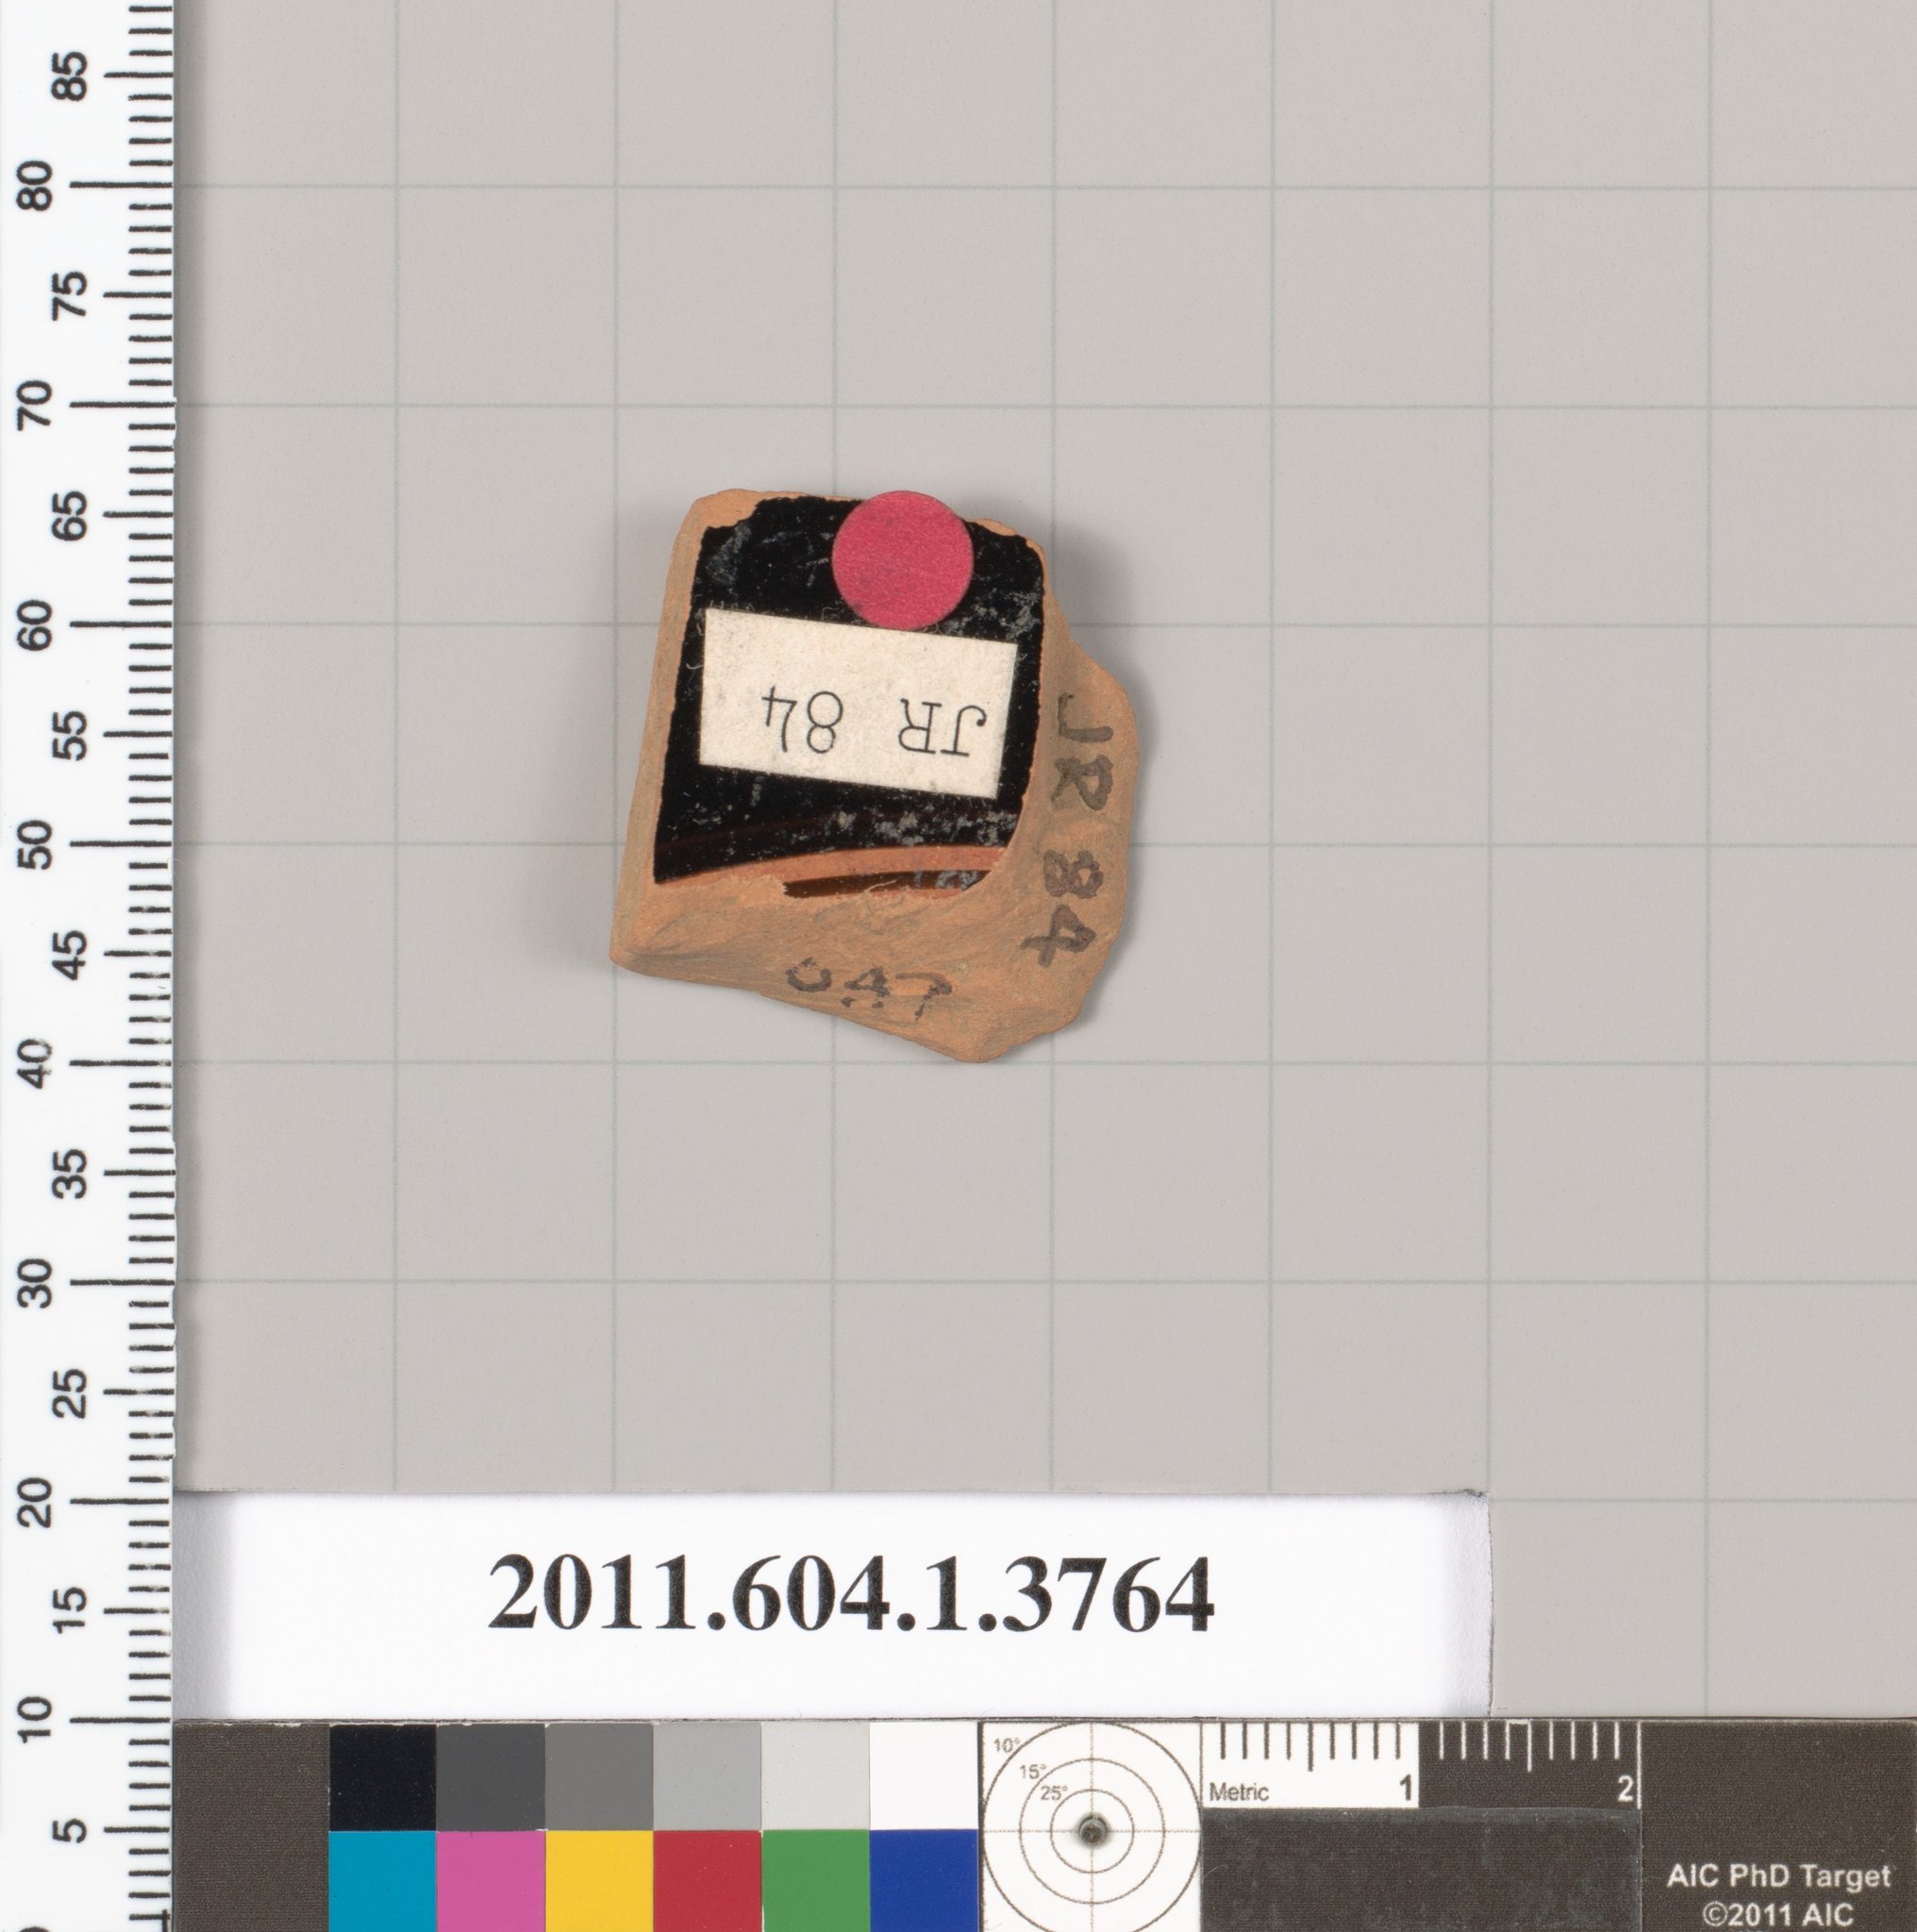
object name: kylix fragment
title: Terracotta fragment of a kylix (drinking cup)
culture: greek, attic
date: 475-451 BCE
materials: terracotta